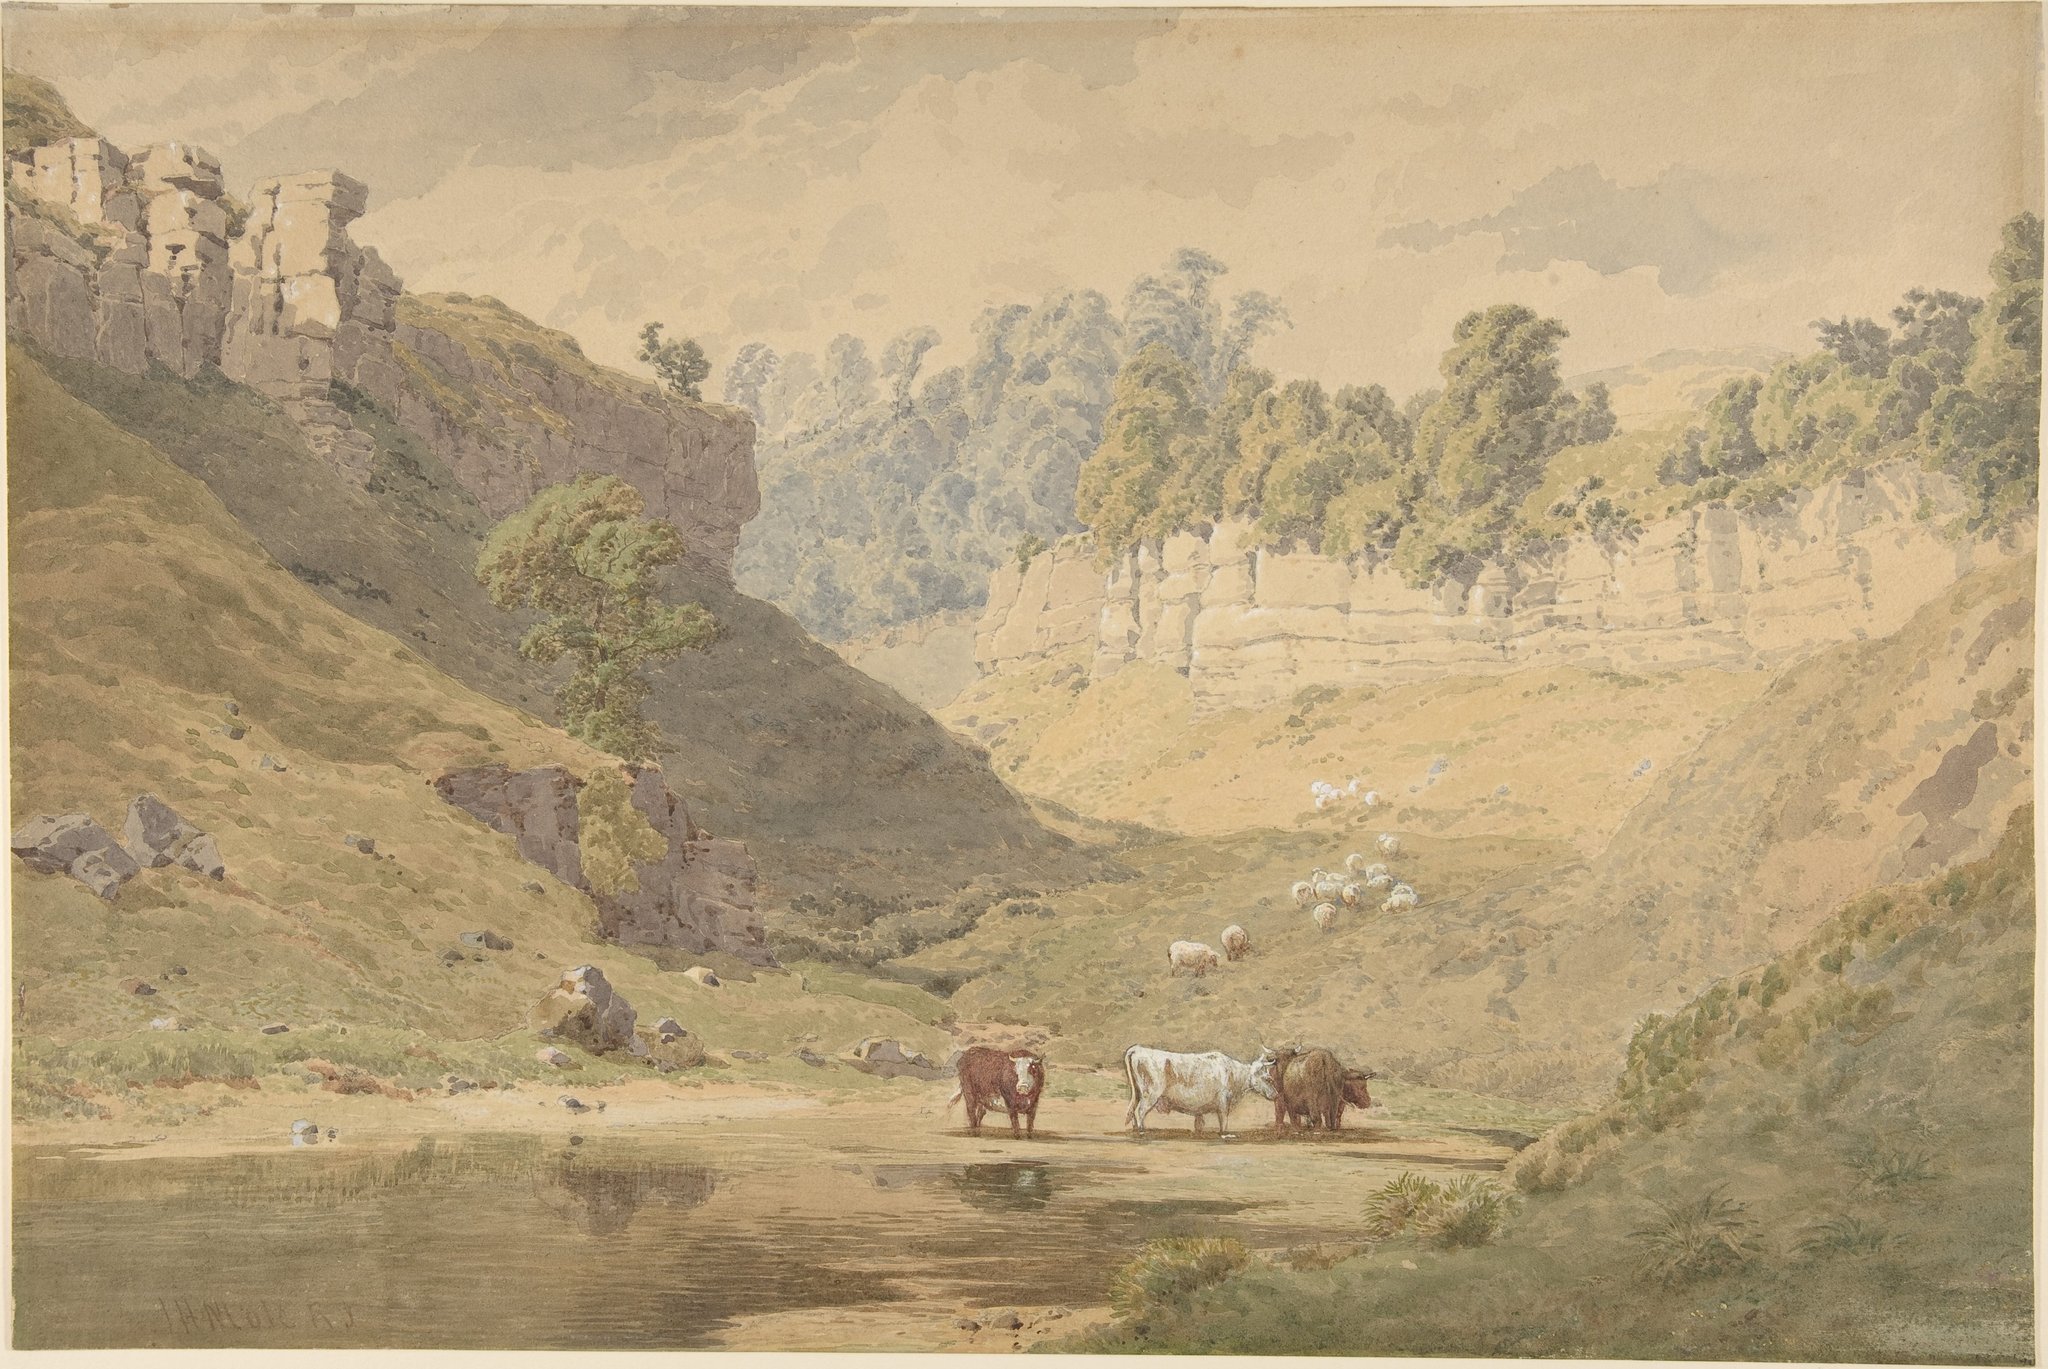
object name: drawing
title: Cattle at a watering hole in a valley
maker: john henry mole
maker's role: artist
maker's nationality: british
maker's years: 1814-1886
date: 1846-1886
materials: gouache, graphite, watercolor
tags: cows,landscapes